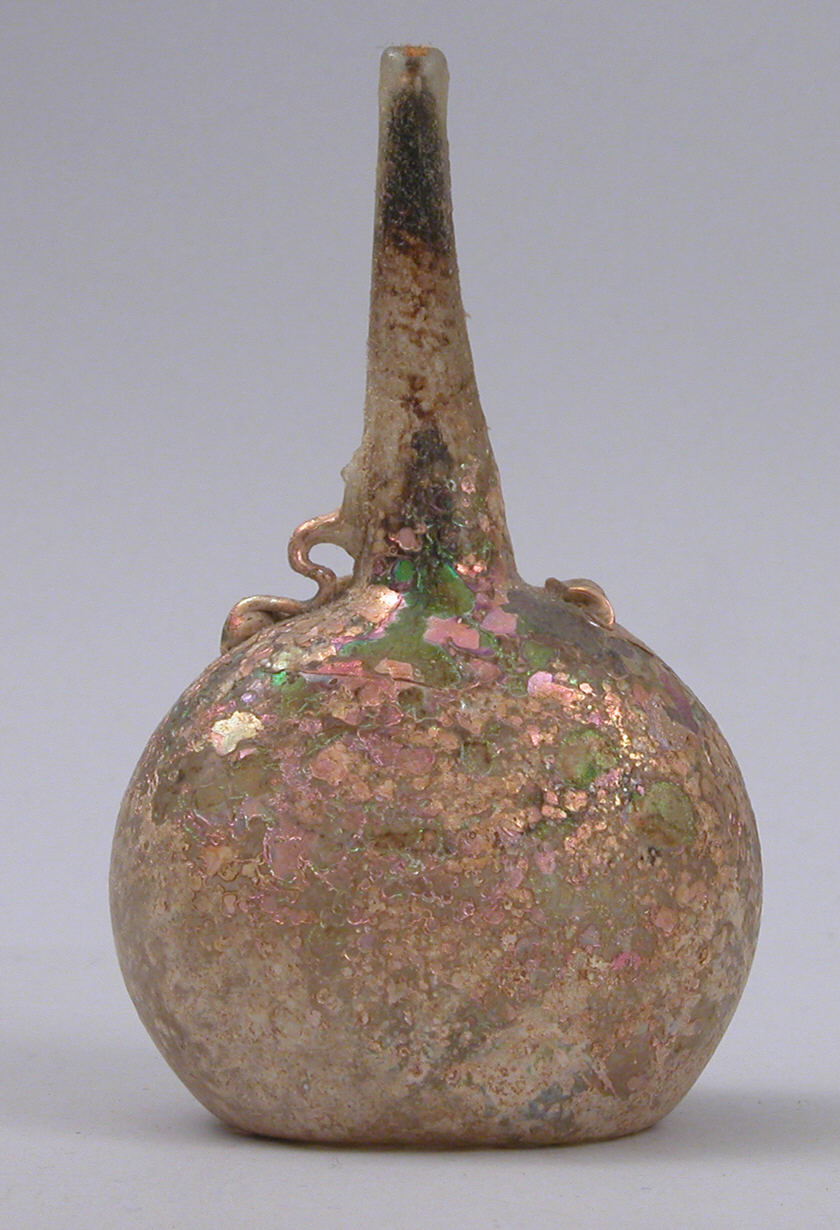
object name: bottle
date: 1201-1400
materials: glass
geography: syria